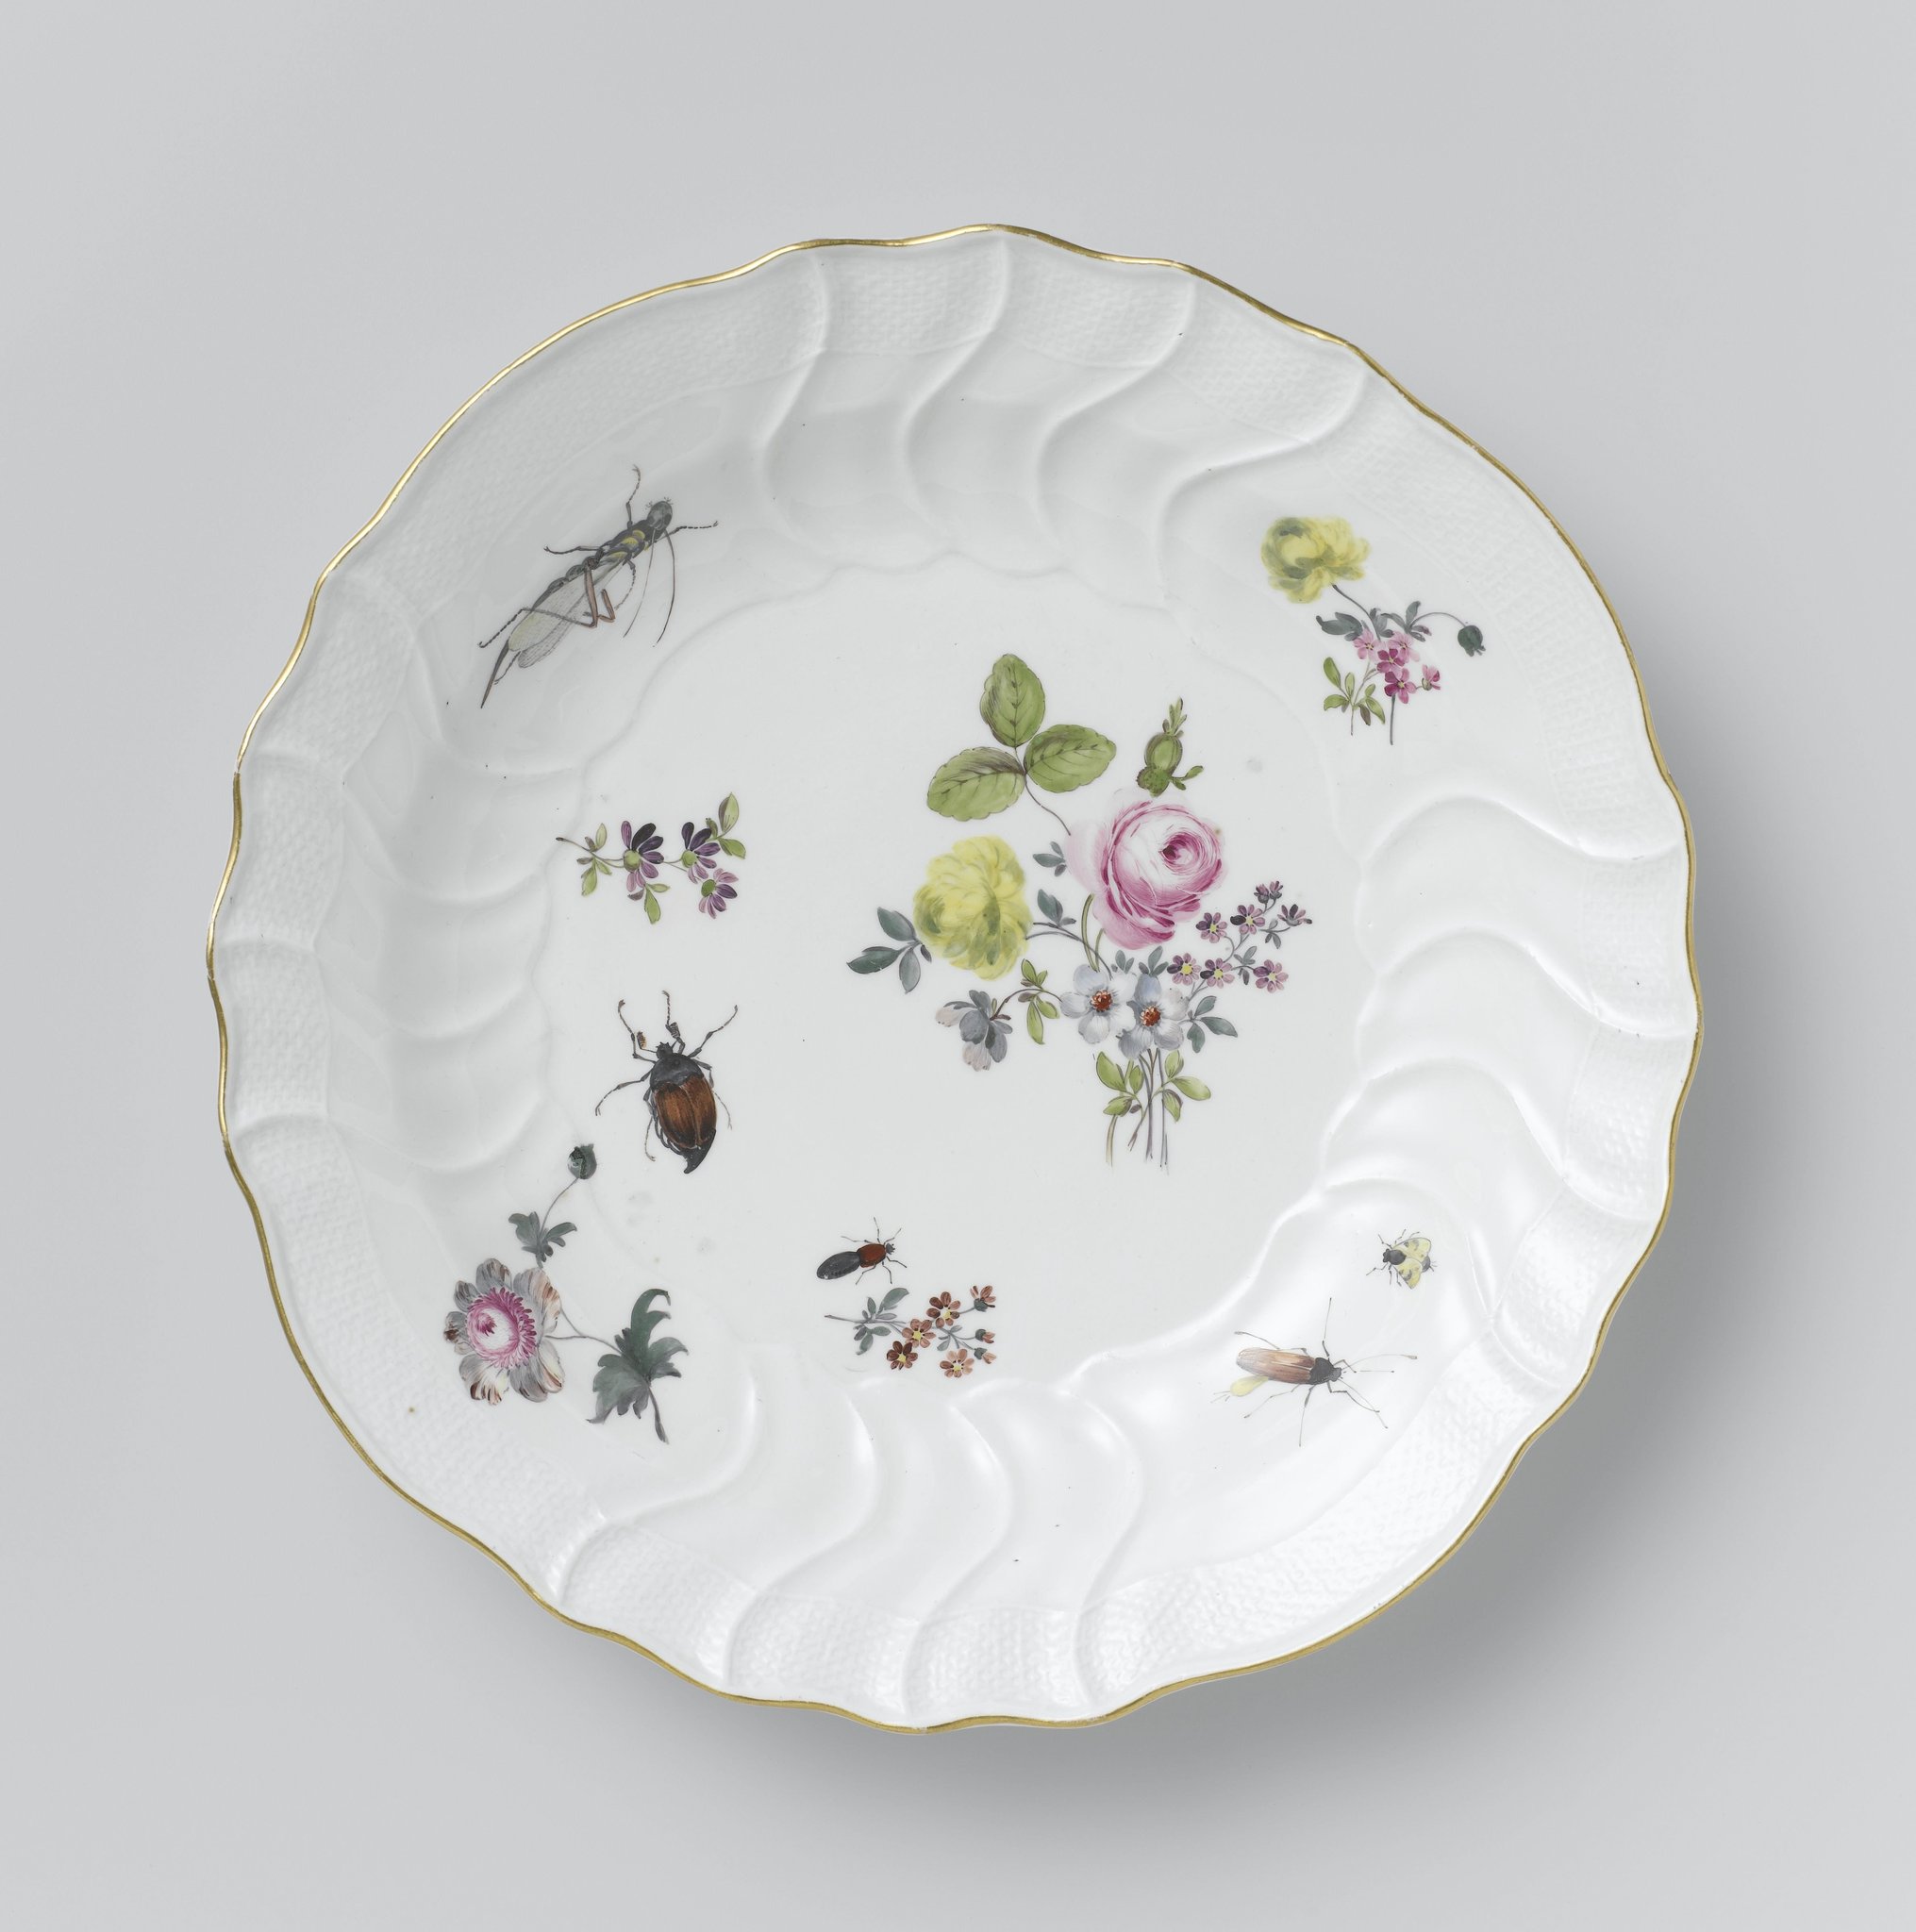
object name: eating drinking utensil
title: Schotel, veelkleurig beschilderd met Deutsche Blumen, insekten en vruchten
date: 1750-1760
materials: porcelain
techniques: painted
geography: meissen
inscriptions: factory mark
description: Ronde schotel van beschilderd porselein. De schotel is beschilderd met Deutsche Blumen, insekten en vruchten. De rand is in reliëf versierd met het Neuozier-patroon. De schotel is gemerkt en hoort bij een servies (BK-17474-1 t/m BK-17474-253).